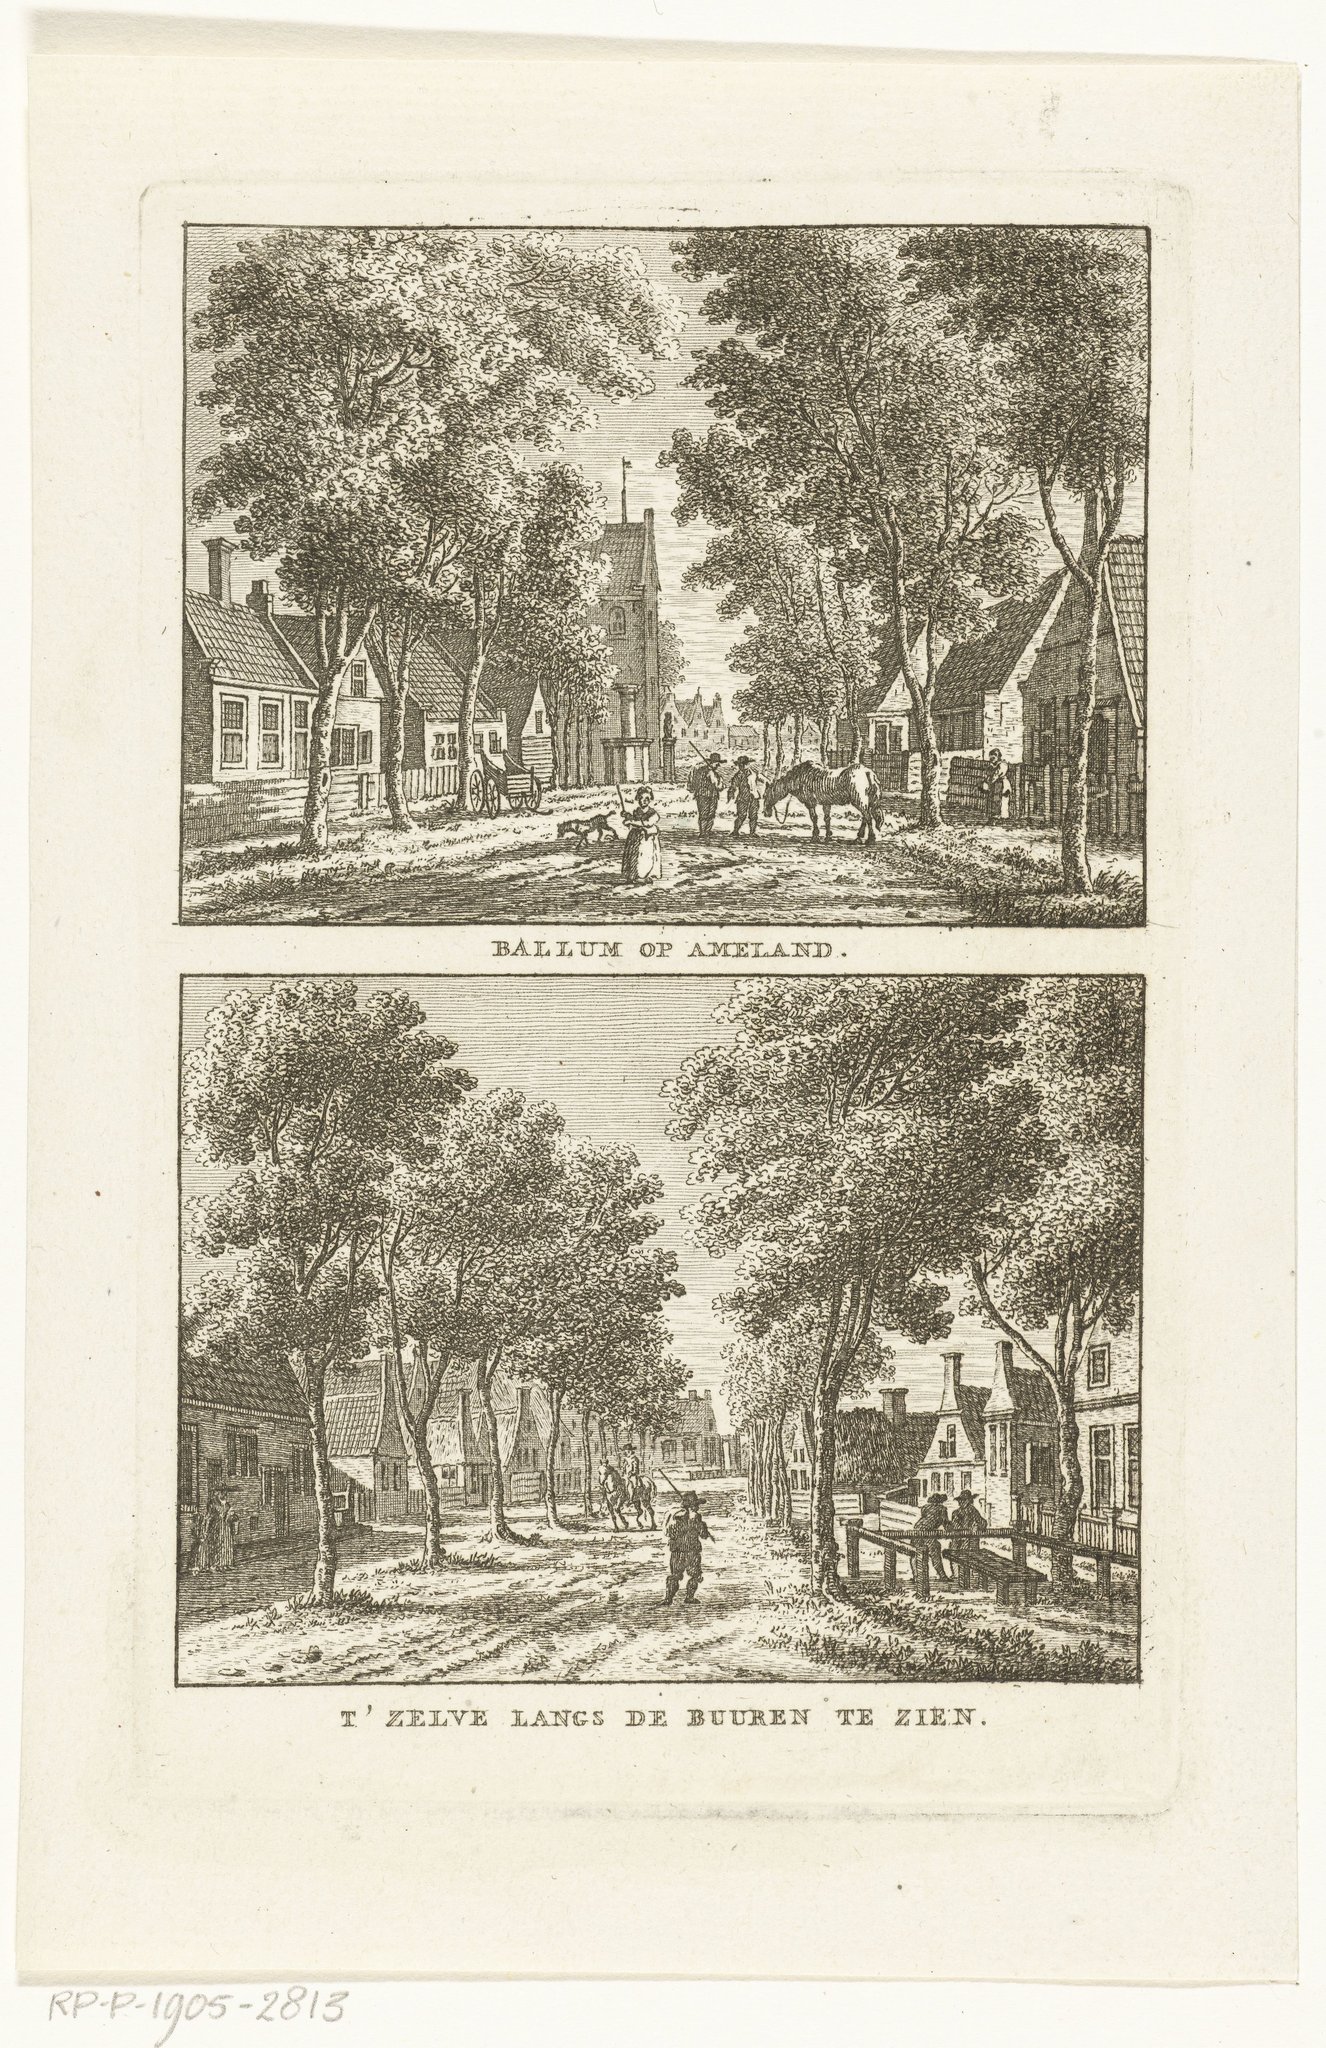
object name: print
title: Twee dorpsgezichten te Ballum op Ameland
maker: carel frederik bendorp (i)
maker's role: print maker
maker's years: 1736-1814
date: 1786-1792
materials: paper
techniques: etching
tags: city-view in general; 'veduta'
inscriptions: collector's mark: Lugt 2228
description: Prent uit: Vaderlandsche gezichten, of afbeeldingen van den tegenwoordigen staat der Vereenigde Nederlanden (…). Amsterdam: Hendrik Gartman, Willem Vermandel en Jan Willem Smit, 1786-1792. Uitgegeven in afleveringen met ieder een eigen bifolium en inhoudsopgave. Alle prenten in deze publicatie zijn gegraveerd door Carel Frederik Bendorp (I) en, in de meeste gevallen, gebaseerd op tekeningen van Jan Bulthuis.